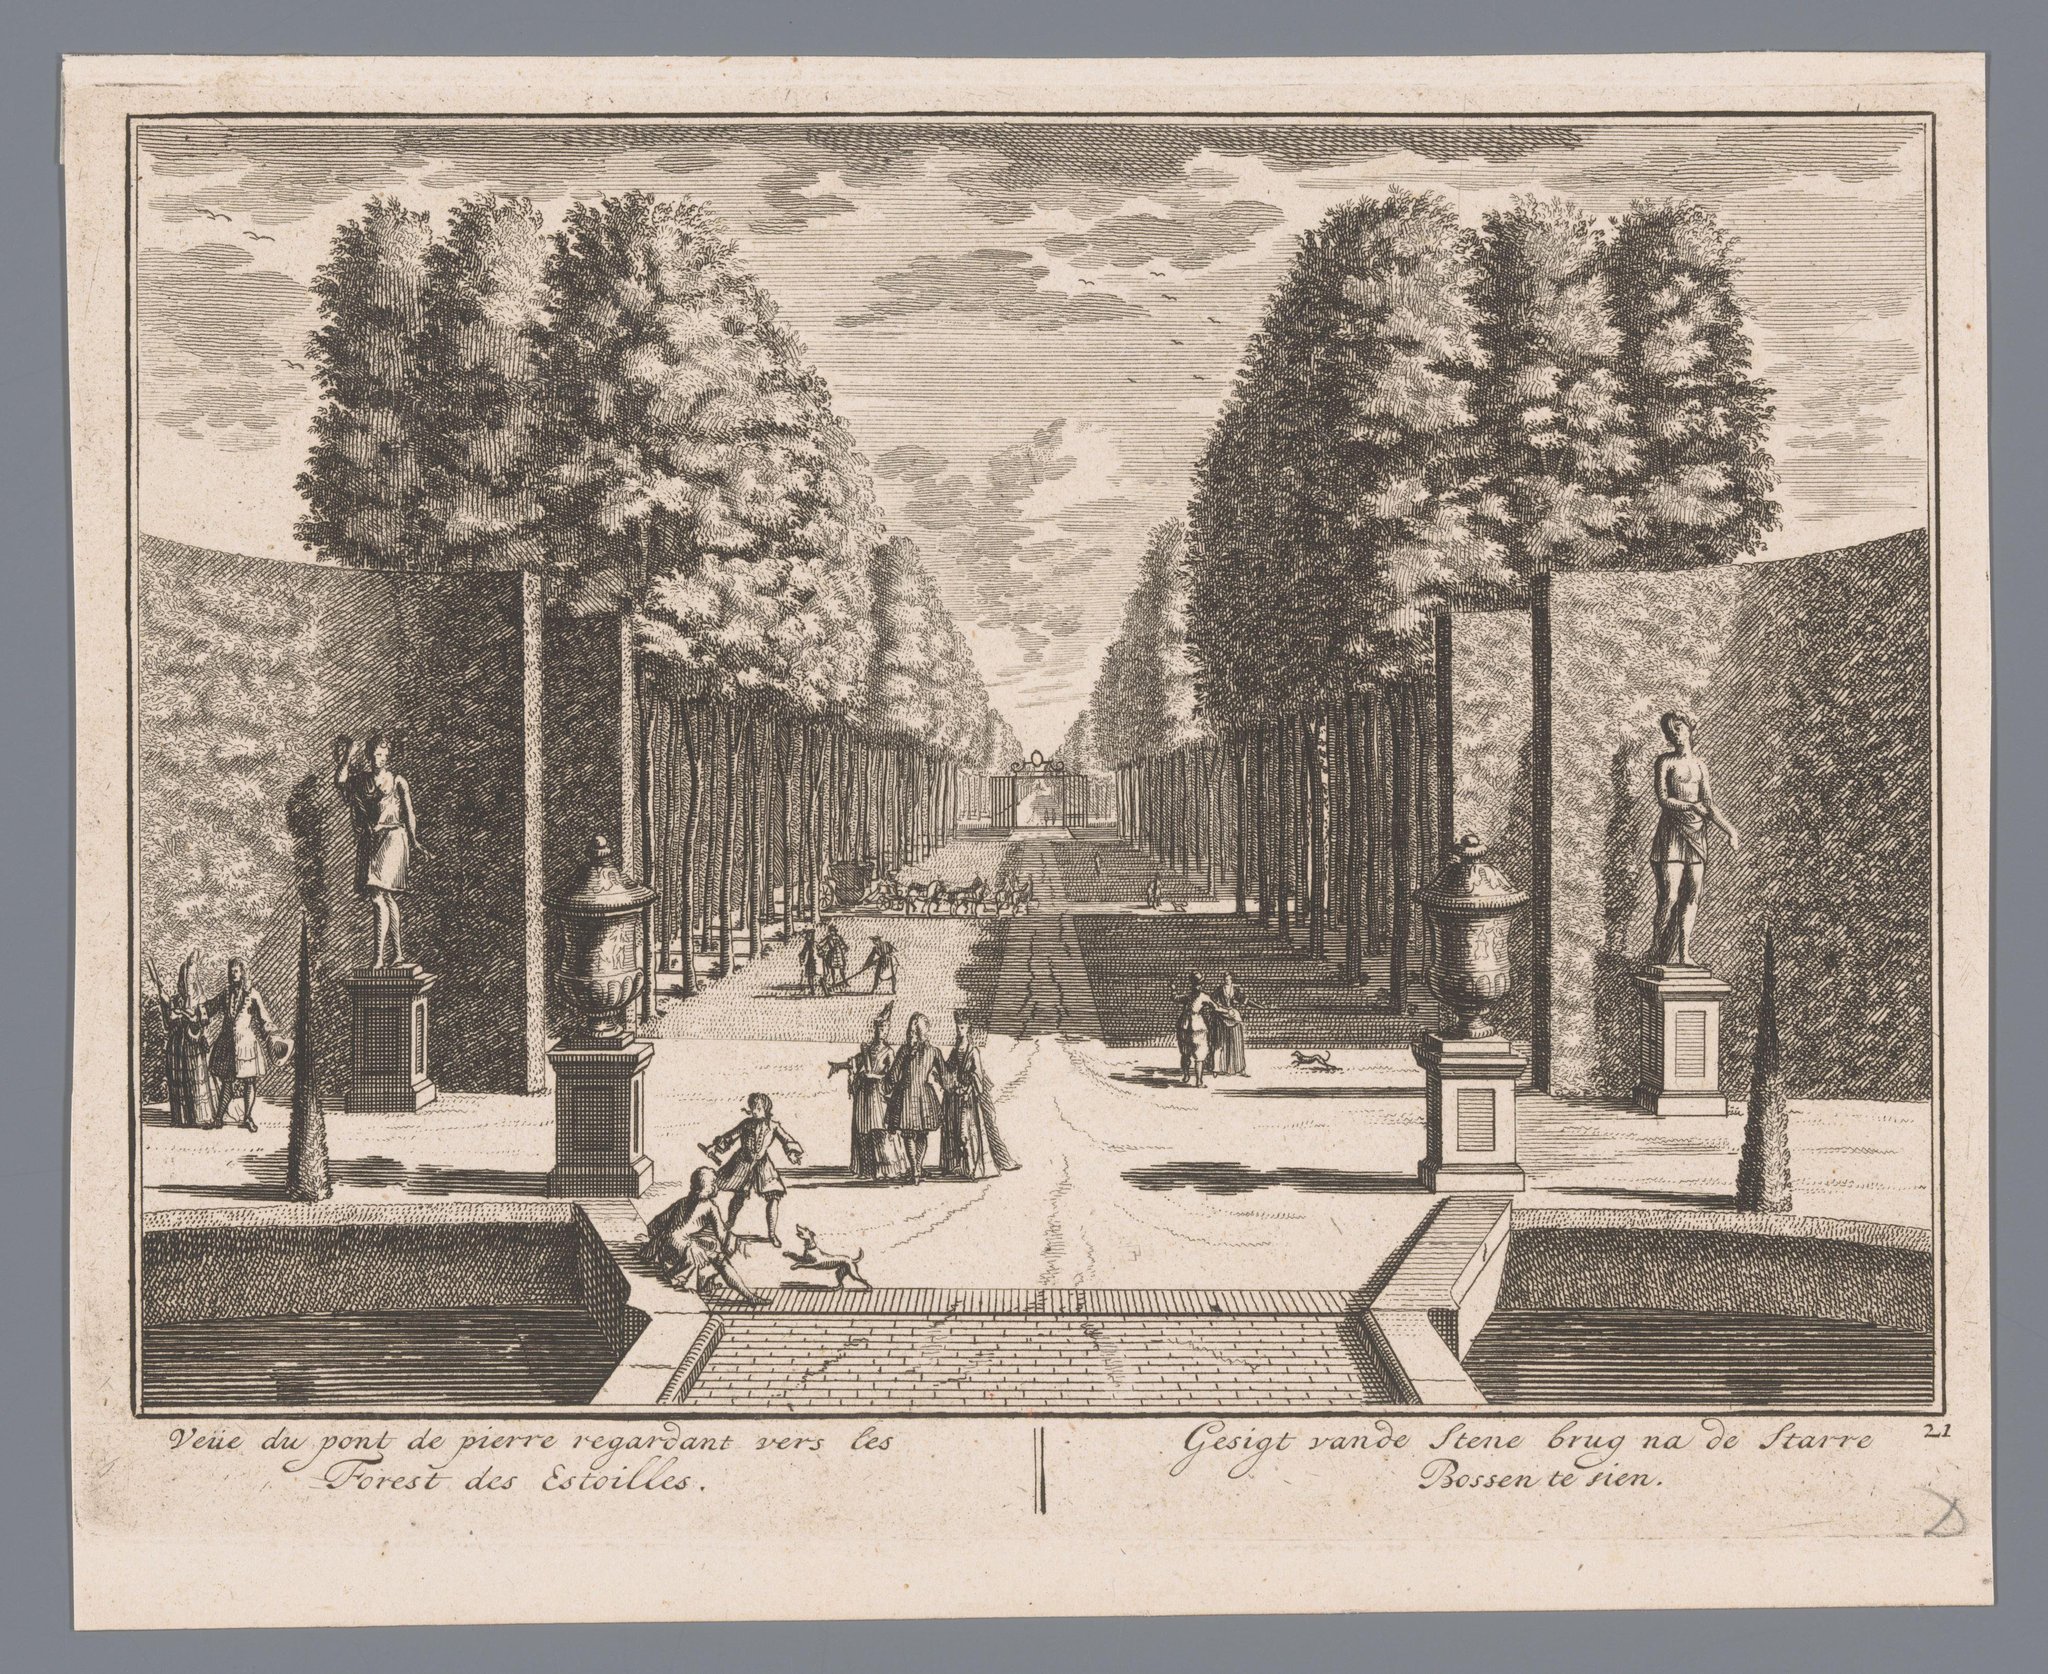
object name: print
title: Gezicht op een laan vanaf de stenen brug bij Slot Zeist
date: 1682-1726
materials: paper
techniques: etching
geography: amsterdam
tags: lane, alley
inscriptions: collector's mark: Lugt 2228